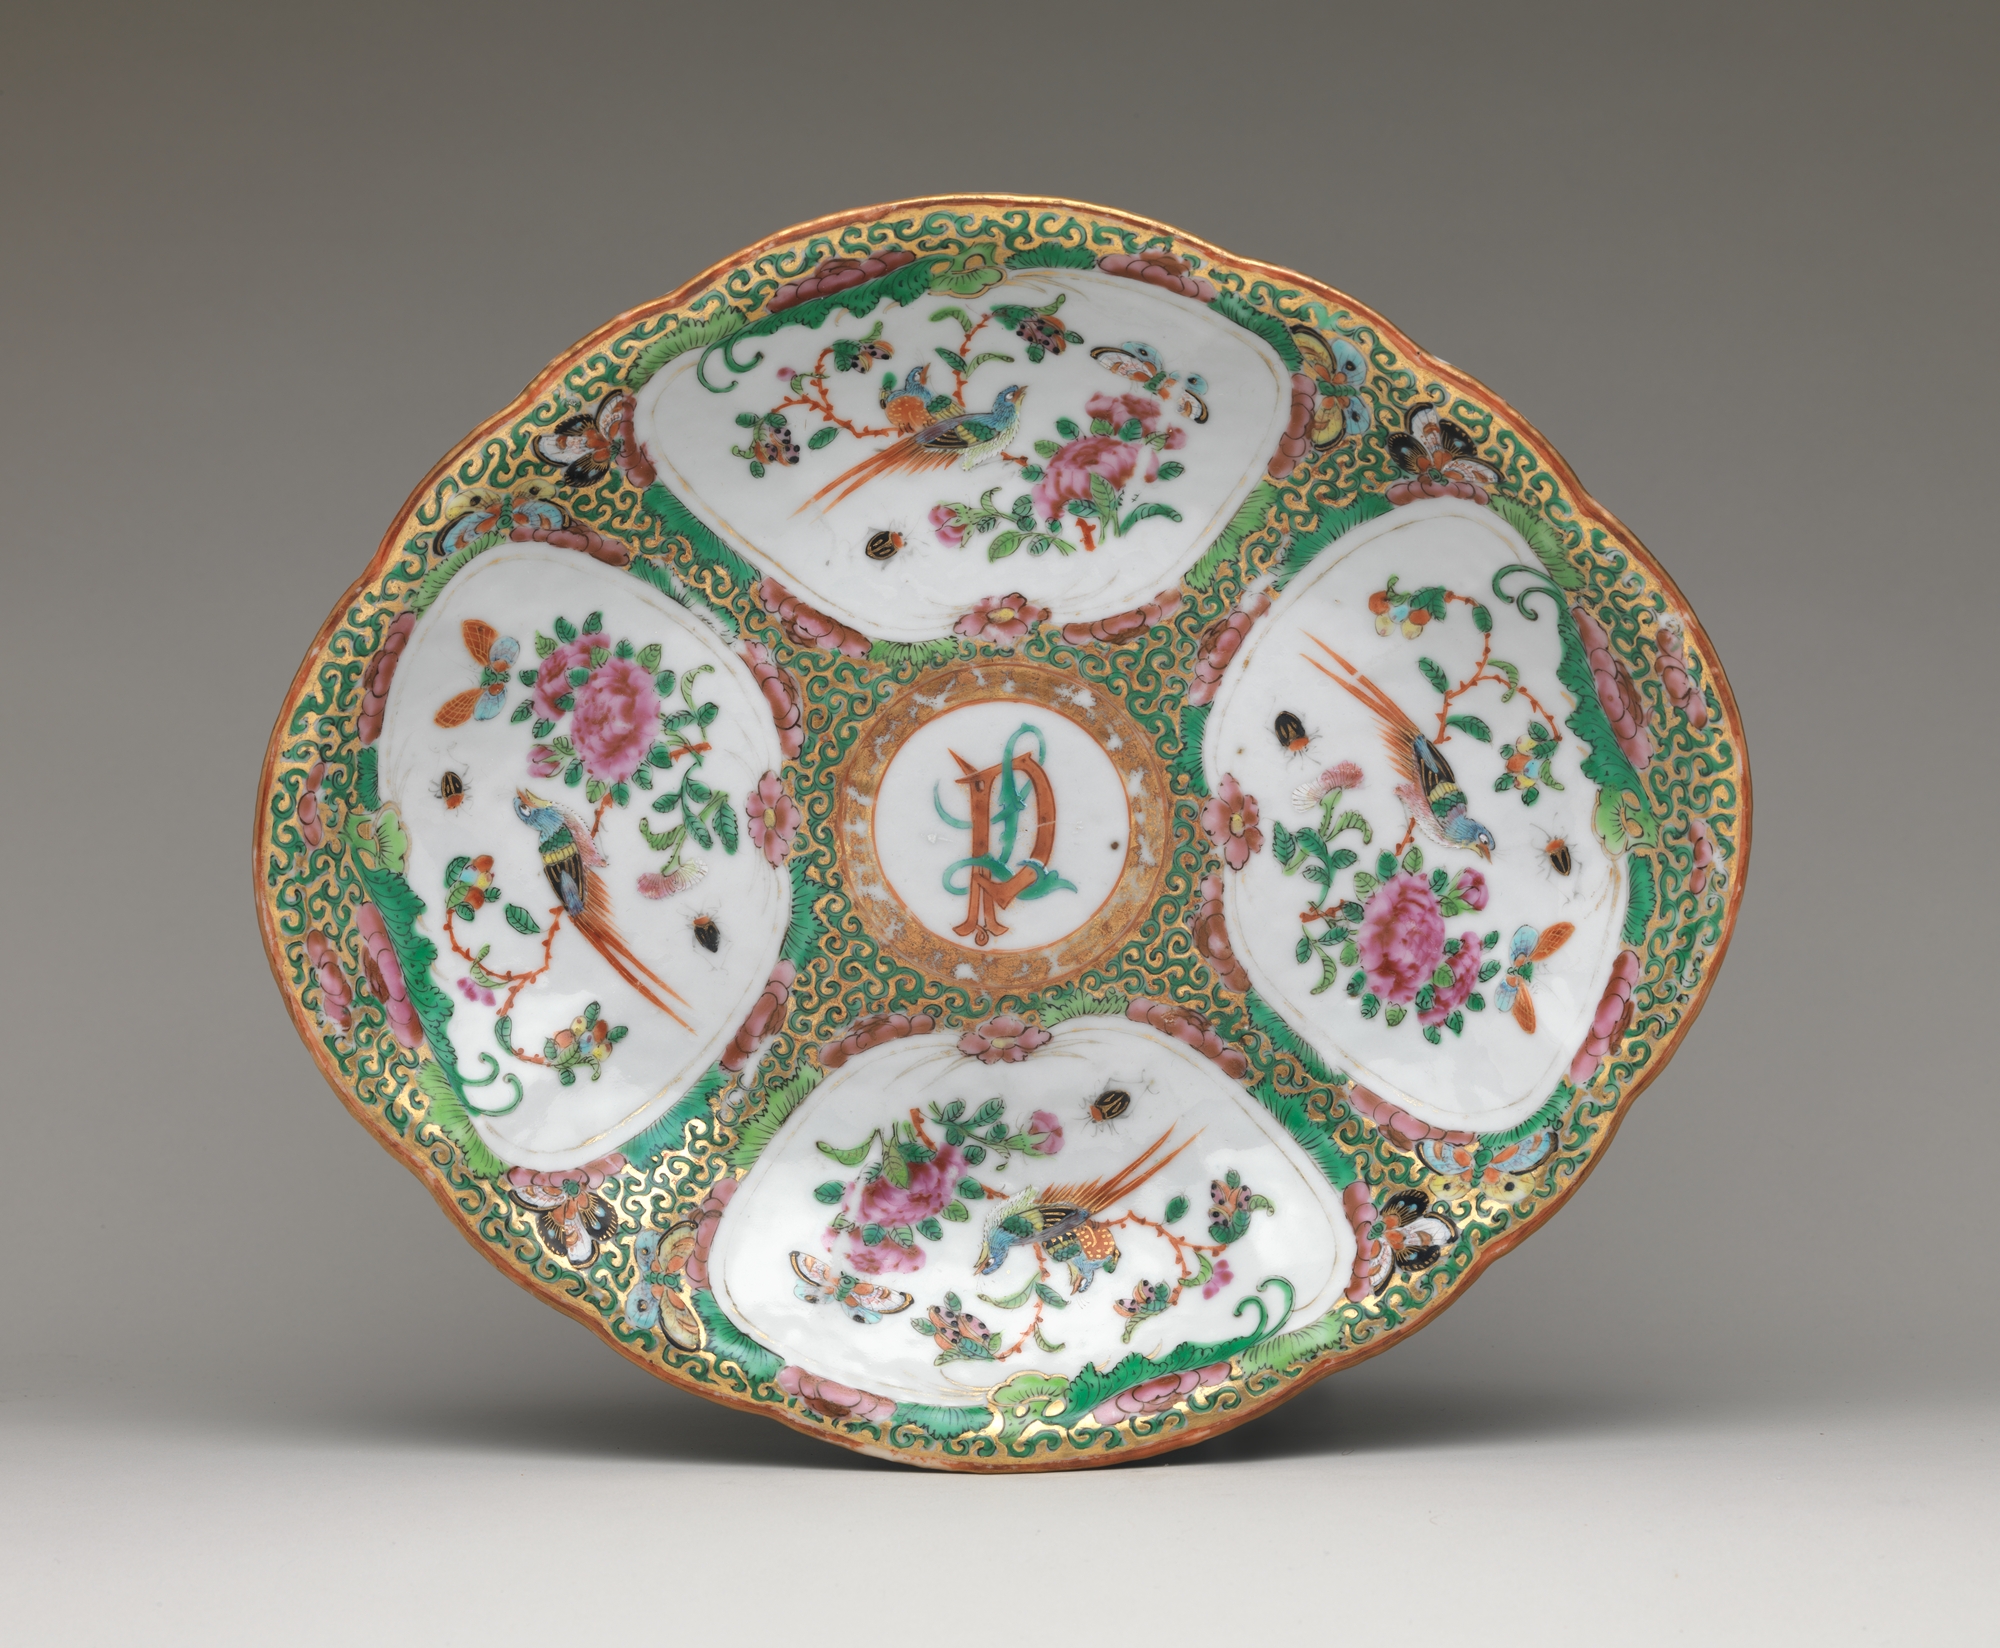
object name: dish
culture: chinese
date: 1860-1866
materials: porcelain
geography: china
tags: birds,flowers